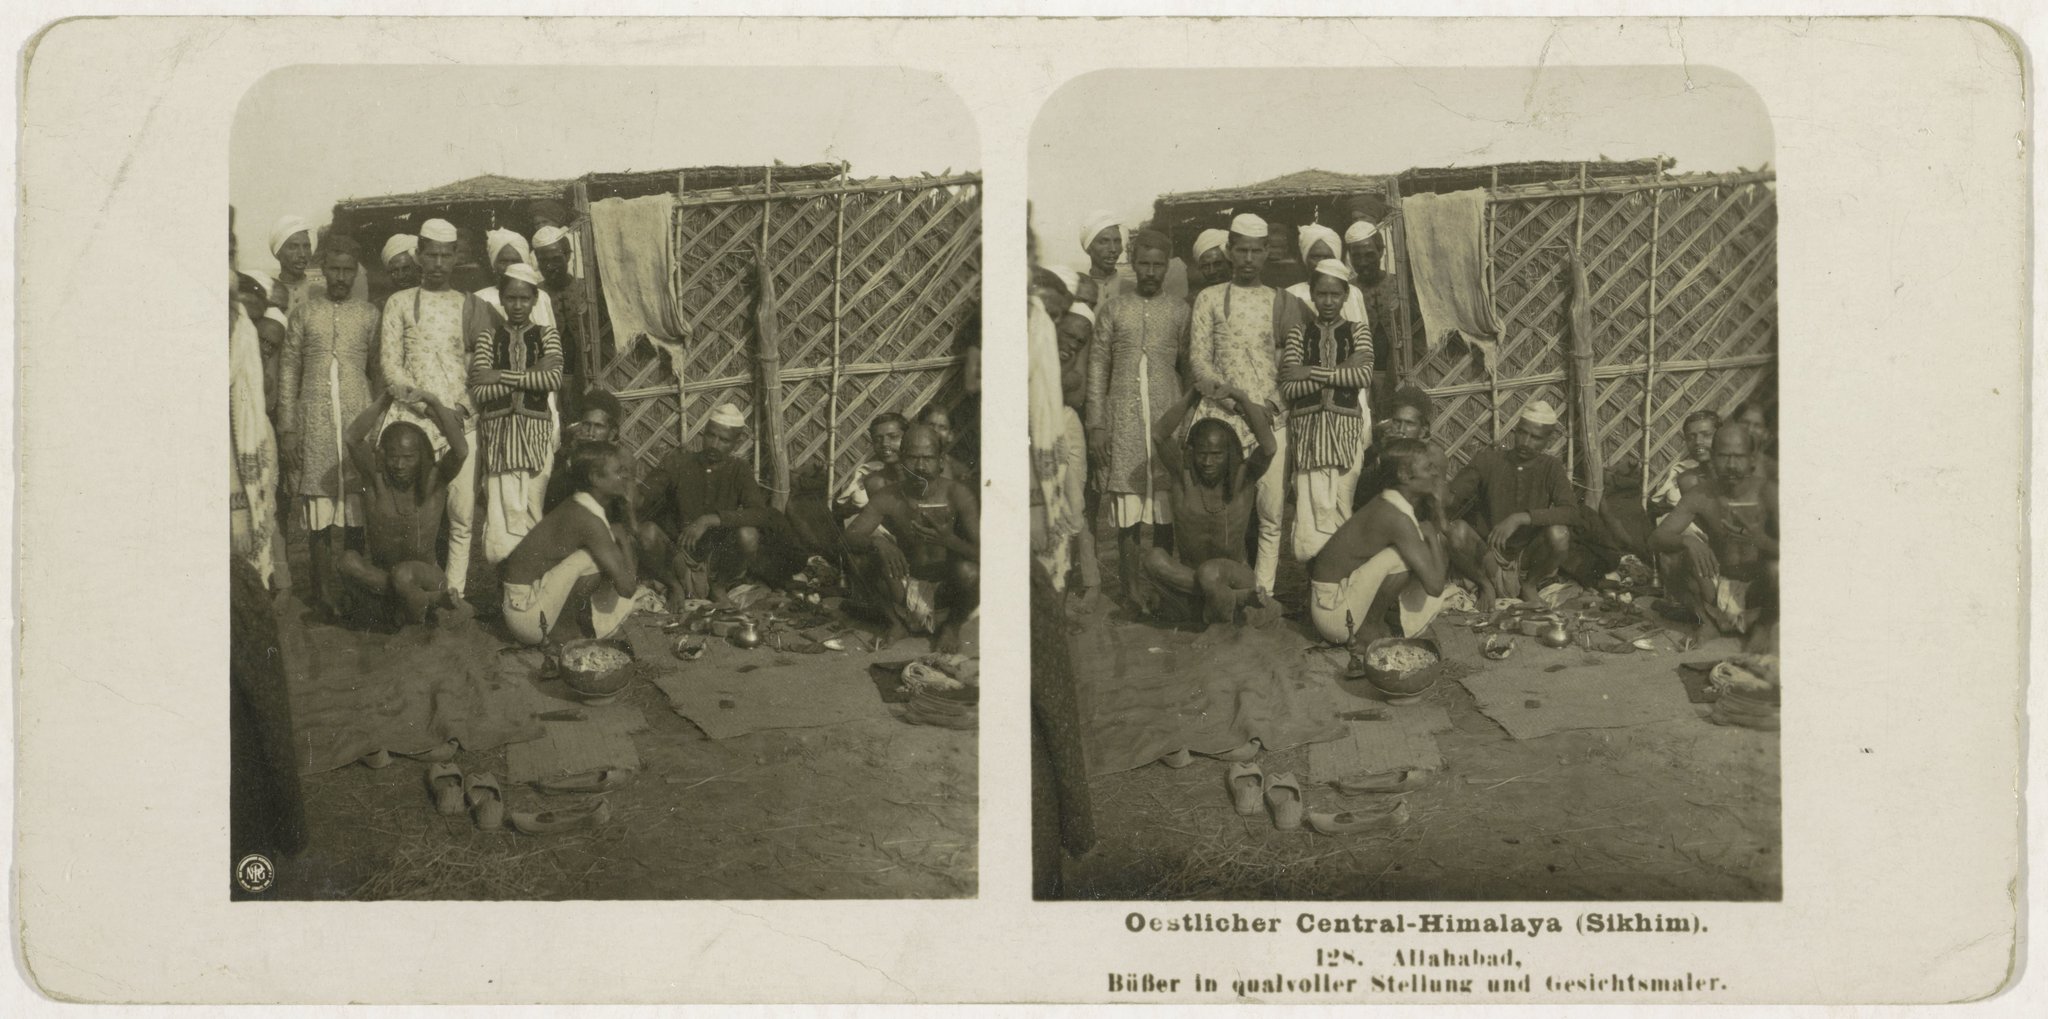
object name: stereograph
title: Allahabad, Büßer in qualvoller Stellung und Gesichtsmaler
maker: Anonymous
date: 1909-1935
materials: paper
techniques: gelatin silver print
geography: steglitz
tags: ritual practices ~ hinduism, buddhism, jainism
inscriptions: number: ‘401’, inscription: ‘M.J. Broekhuijsen’, number: ‘128.’